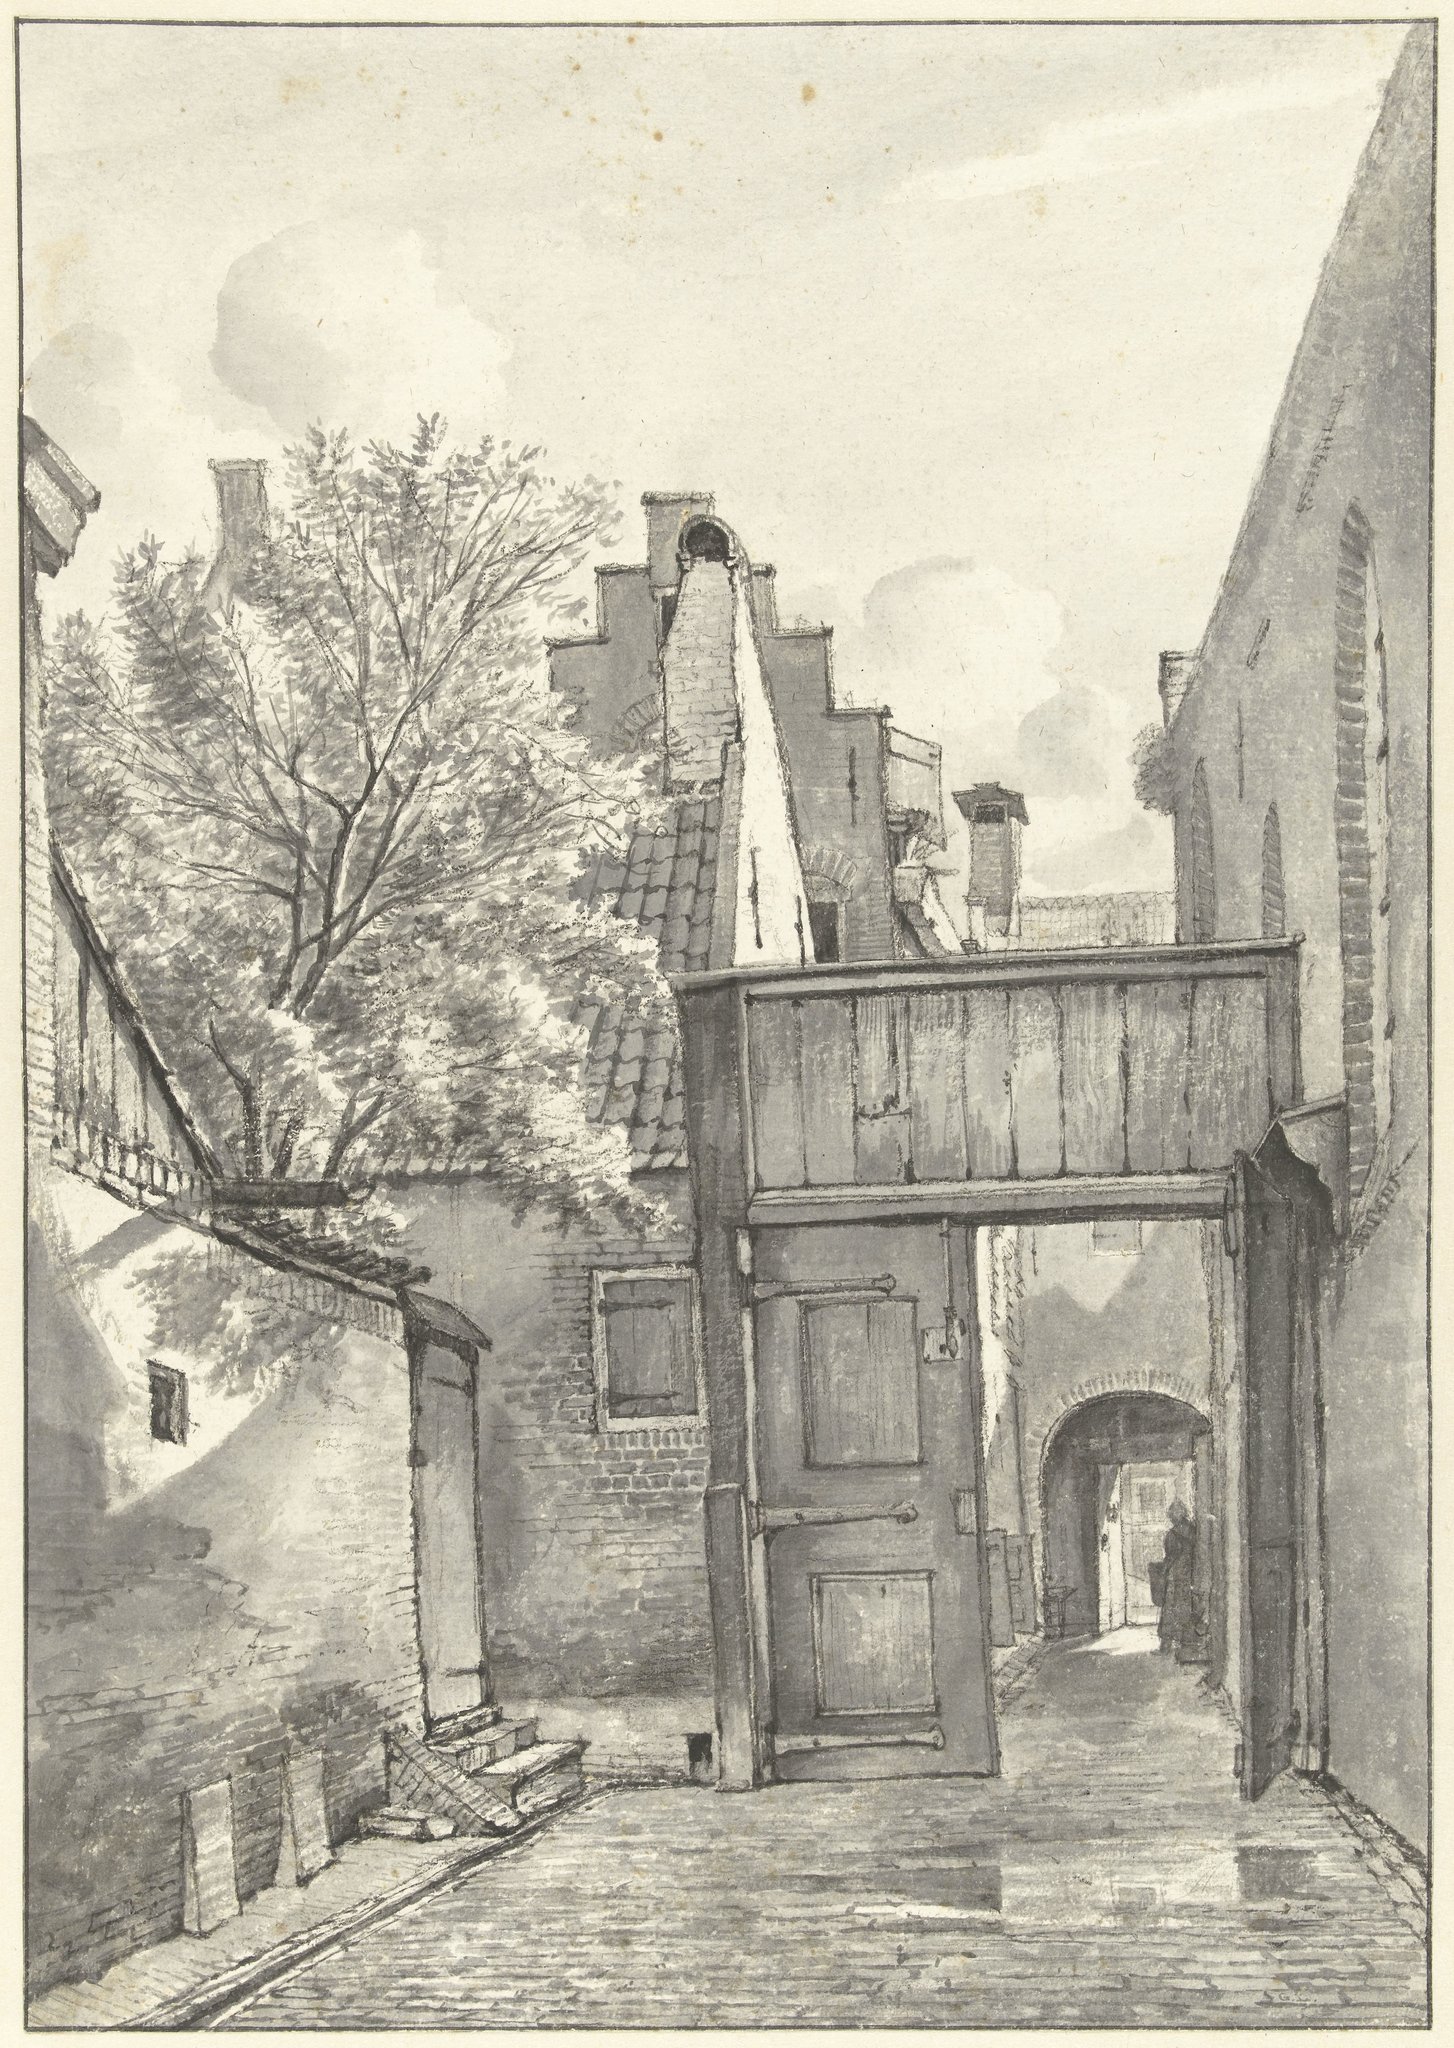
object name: drawing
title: Binnenplaats en steeg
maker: gerrit lamberts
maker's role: bookseller, draughtsman, print maker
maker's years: 1776-1850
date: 1820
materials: chalk, paper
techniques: brush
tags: lane, alley